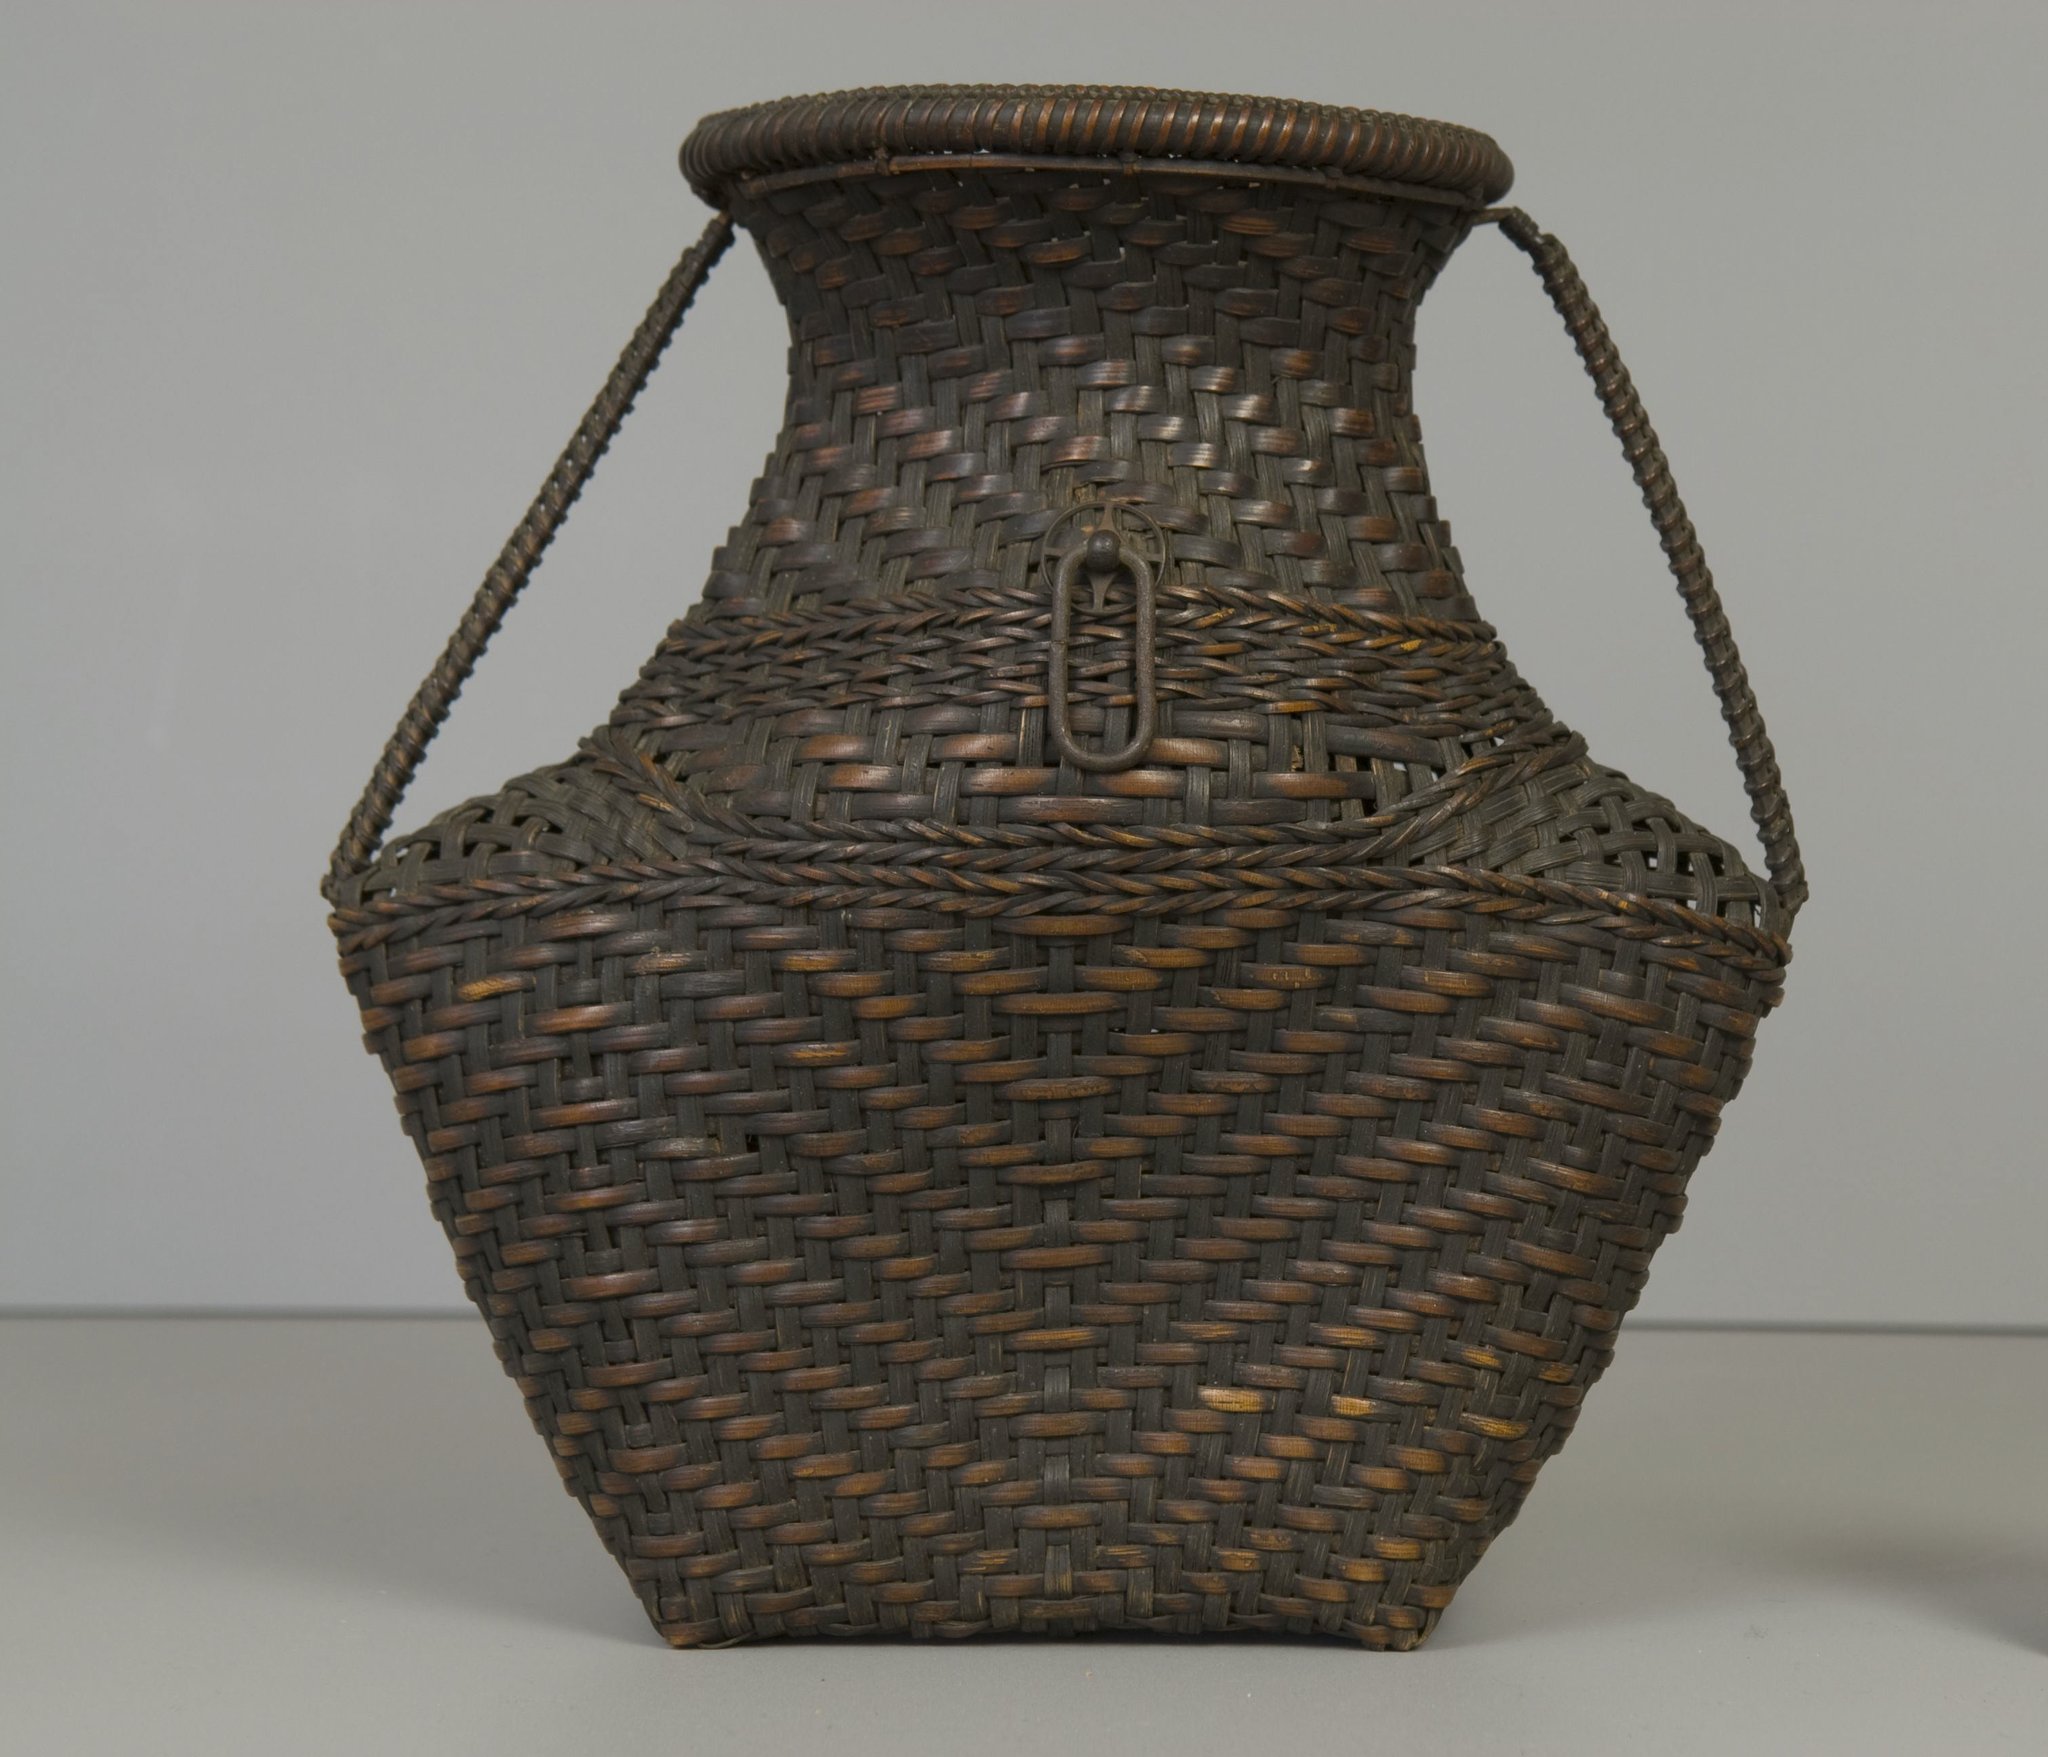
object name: basket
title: Karamono-Style Basket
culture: china or japan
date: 1801-1900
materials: bamboo, rattan